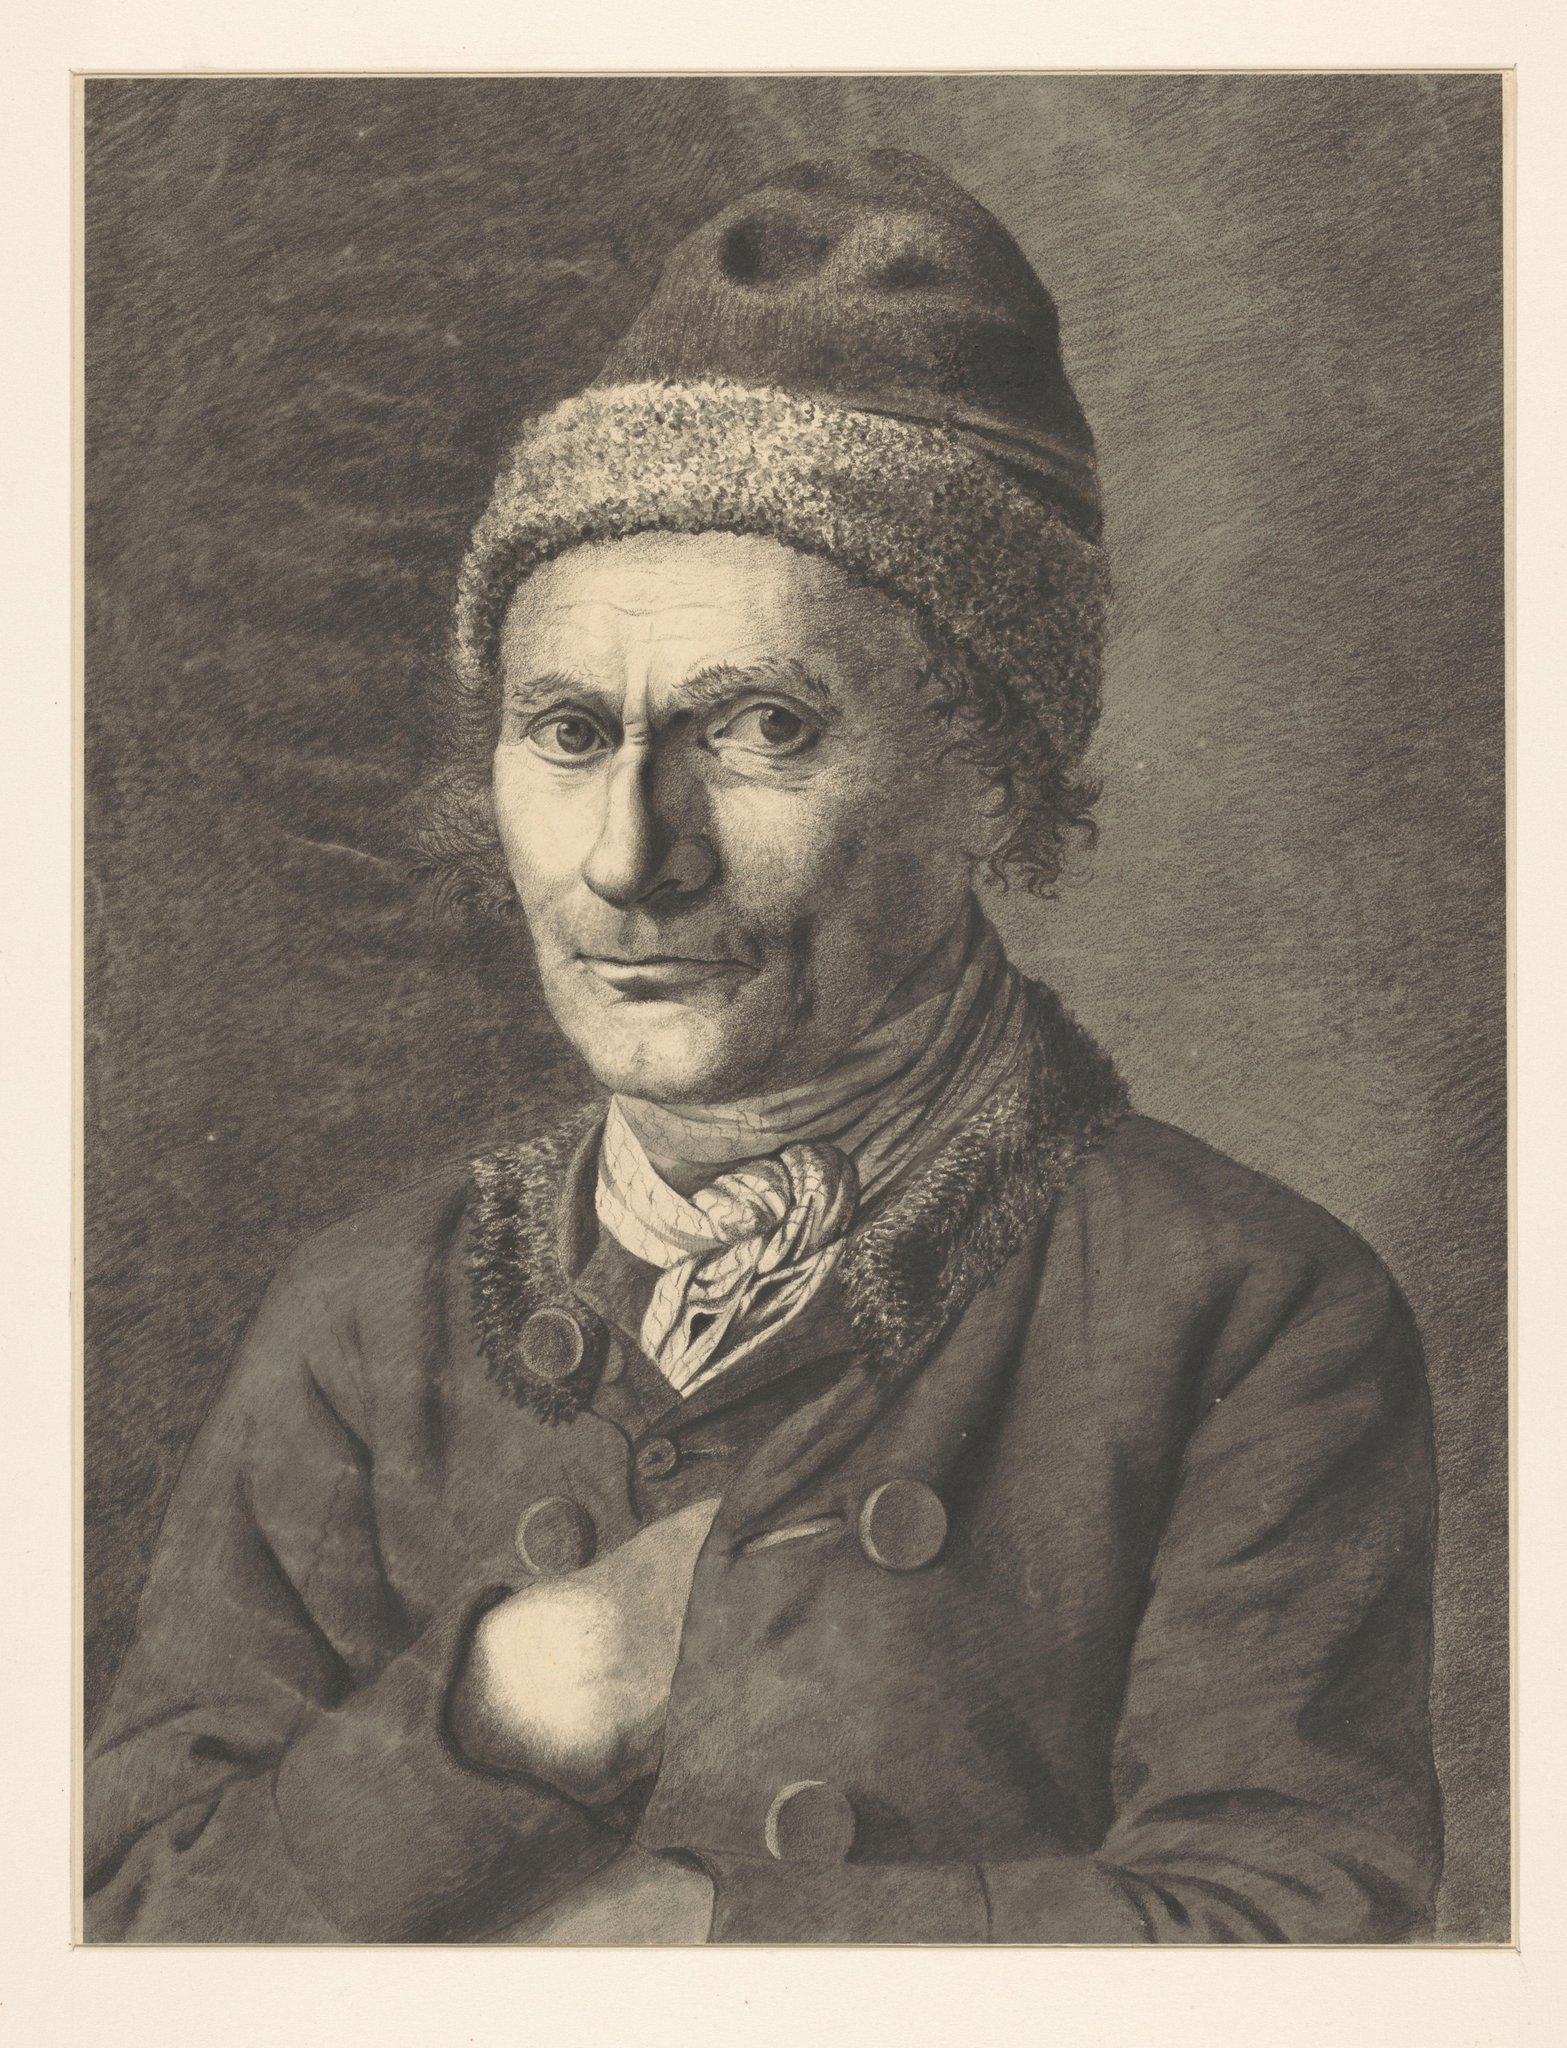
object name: drawing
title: Portret van Jacobus Dorsman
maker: Anonymous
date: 1775-1875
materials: chalk, paper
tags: leiden, draughtsman, jacobus dorsman, historical persons, portrait, self-portrait of painter, portrait, self-portrait of artist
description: Portret van de Leidsche miniatuurschilder Jacobus Dorsman.